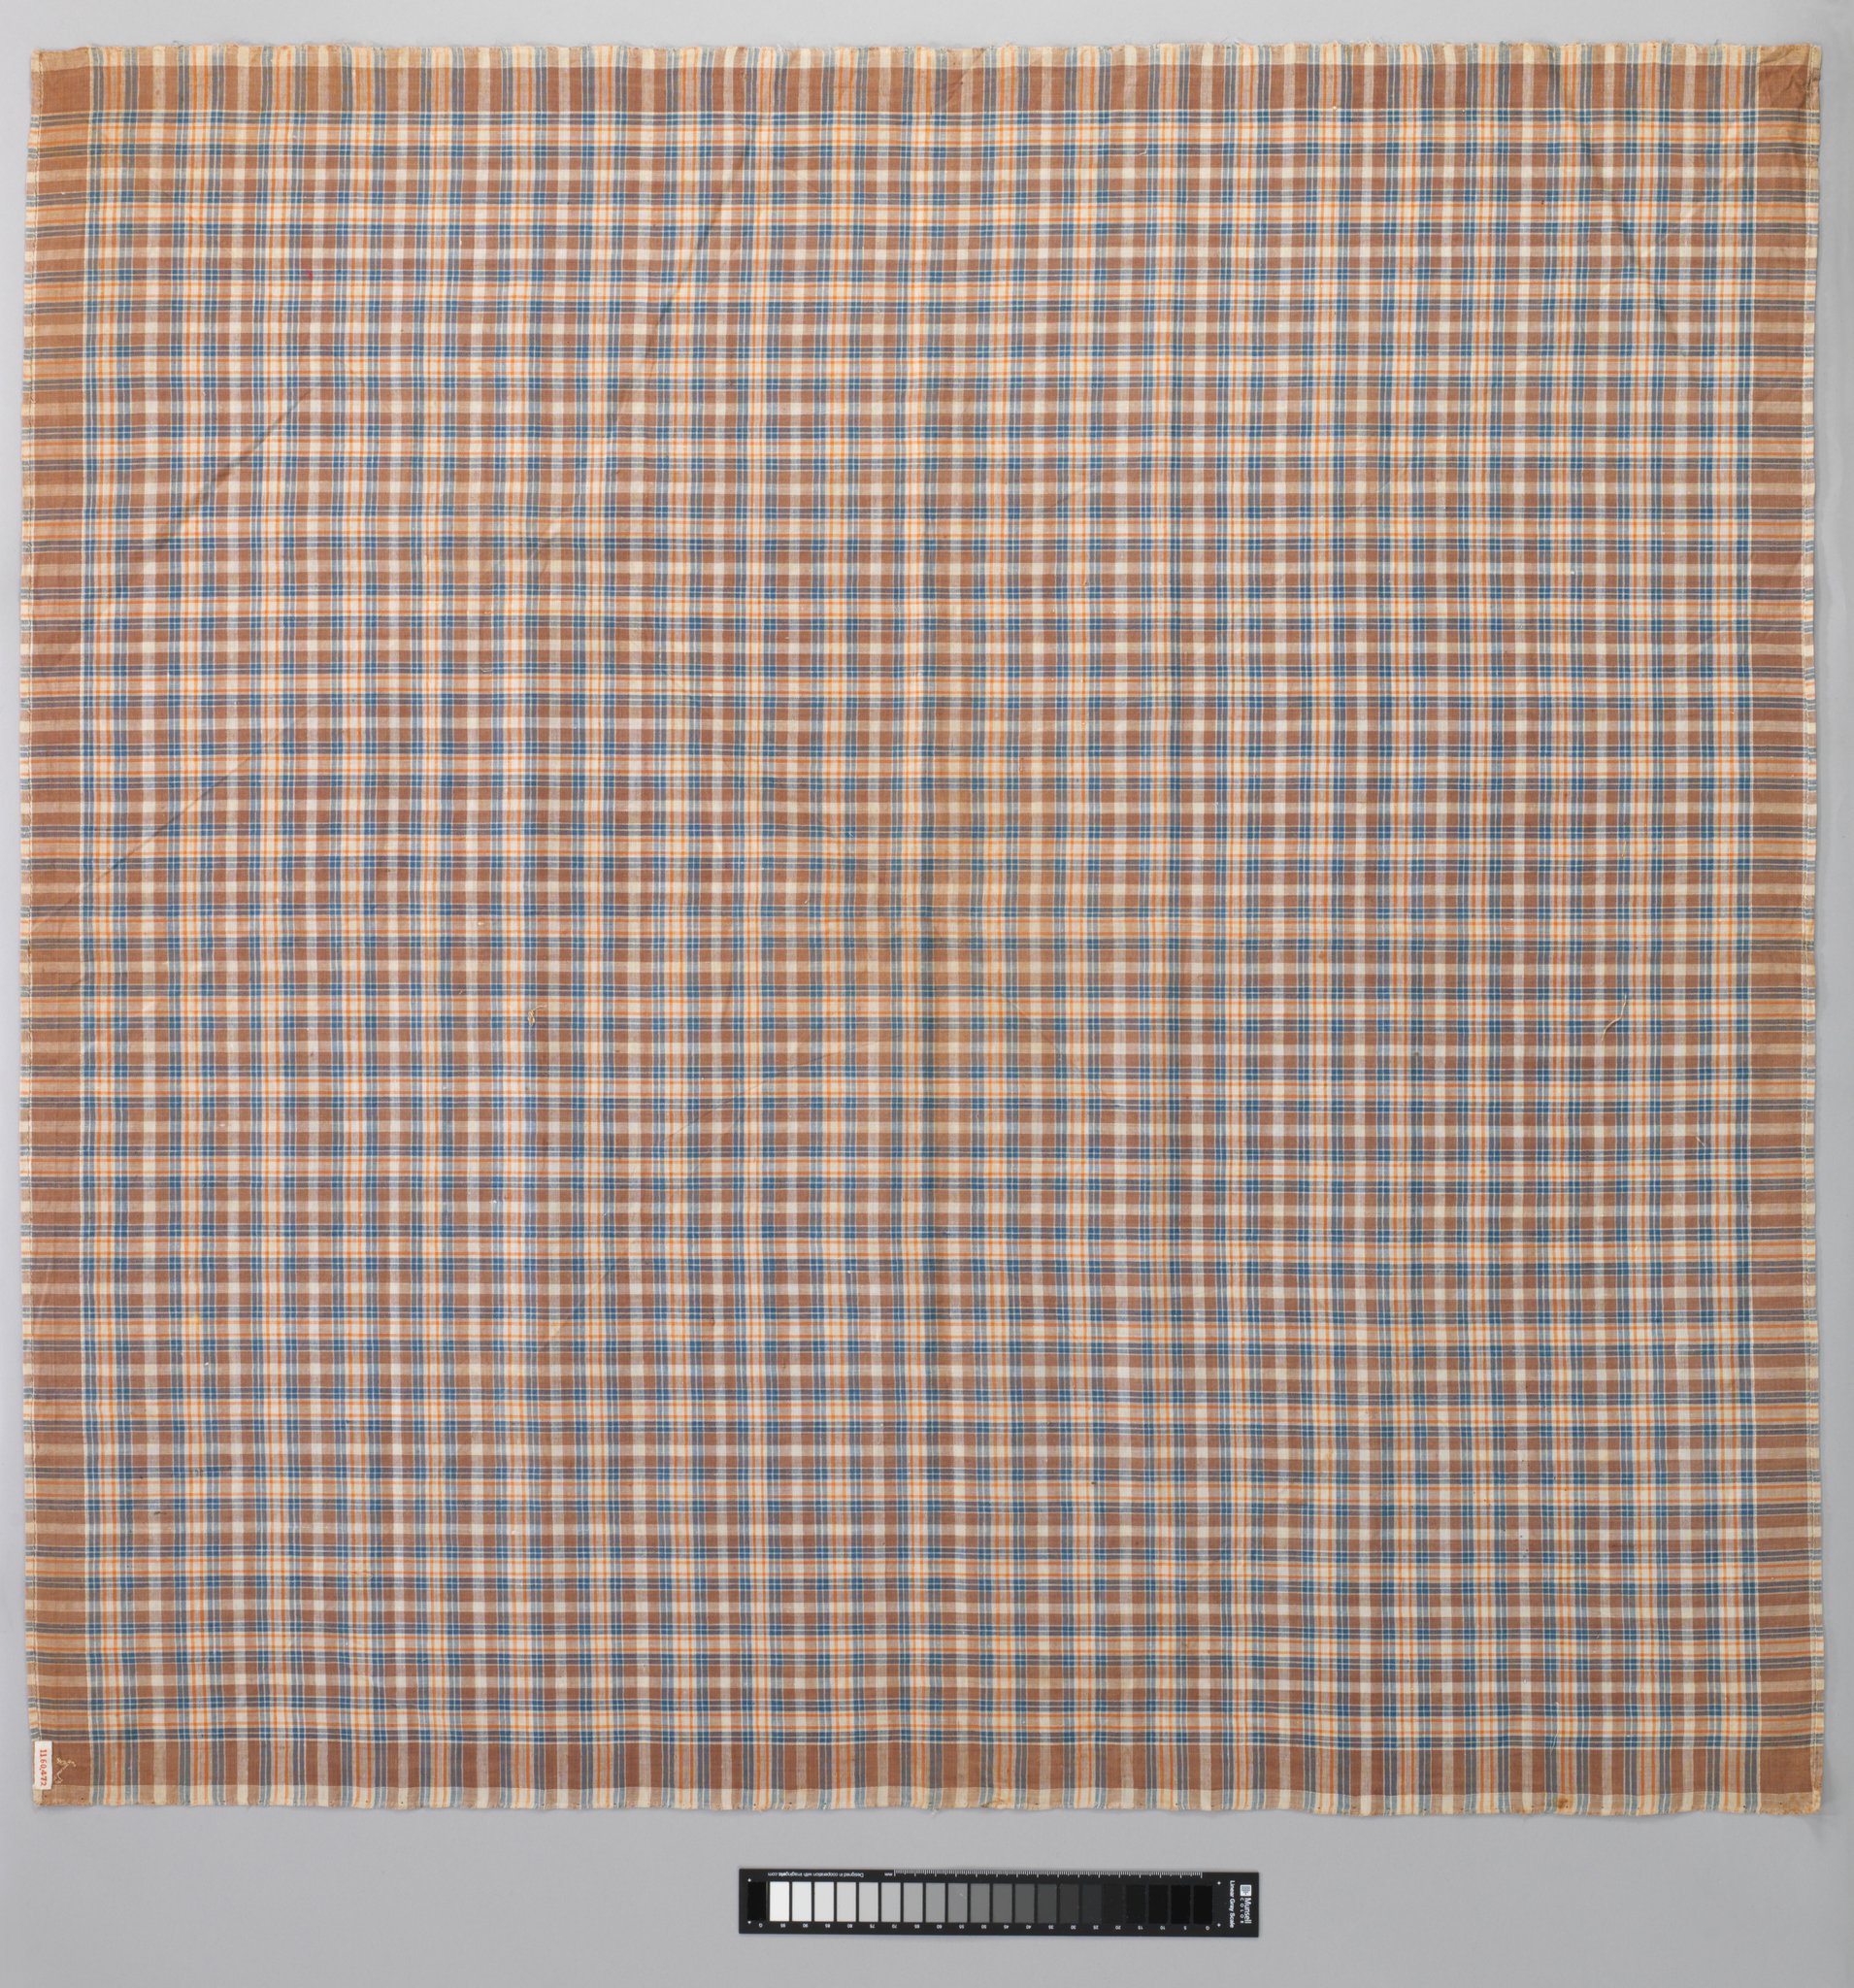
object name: handkerchief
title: Man's handkerchief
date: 1801-1900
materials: cotton